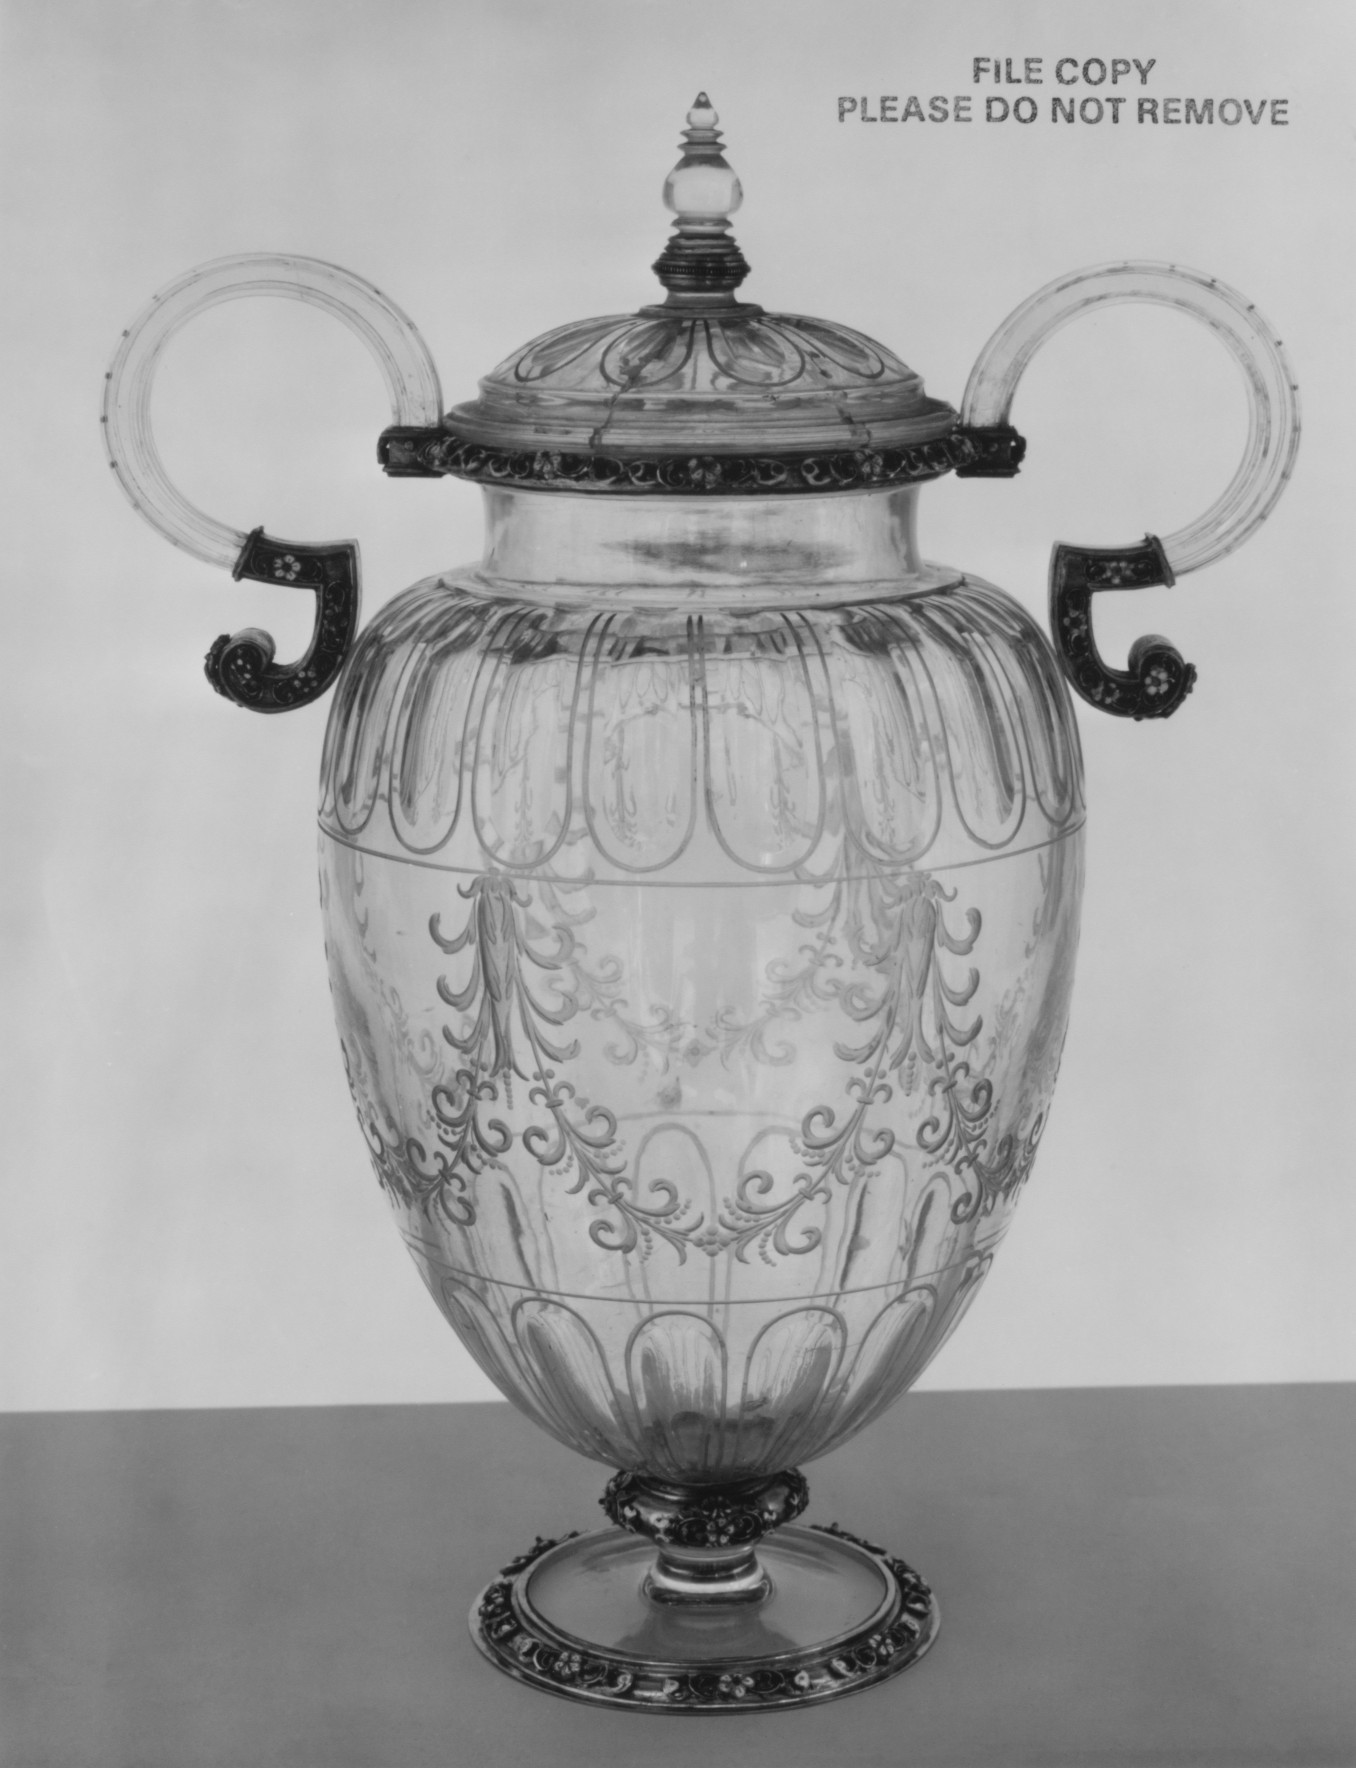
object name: vase with cover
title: Two-handled vase with cover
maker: reinhold vasters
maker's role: designer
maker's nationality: german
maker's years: 1827-1909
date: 1851-1900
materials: enamel, gold, quartz